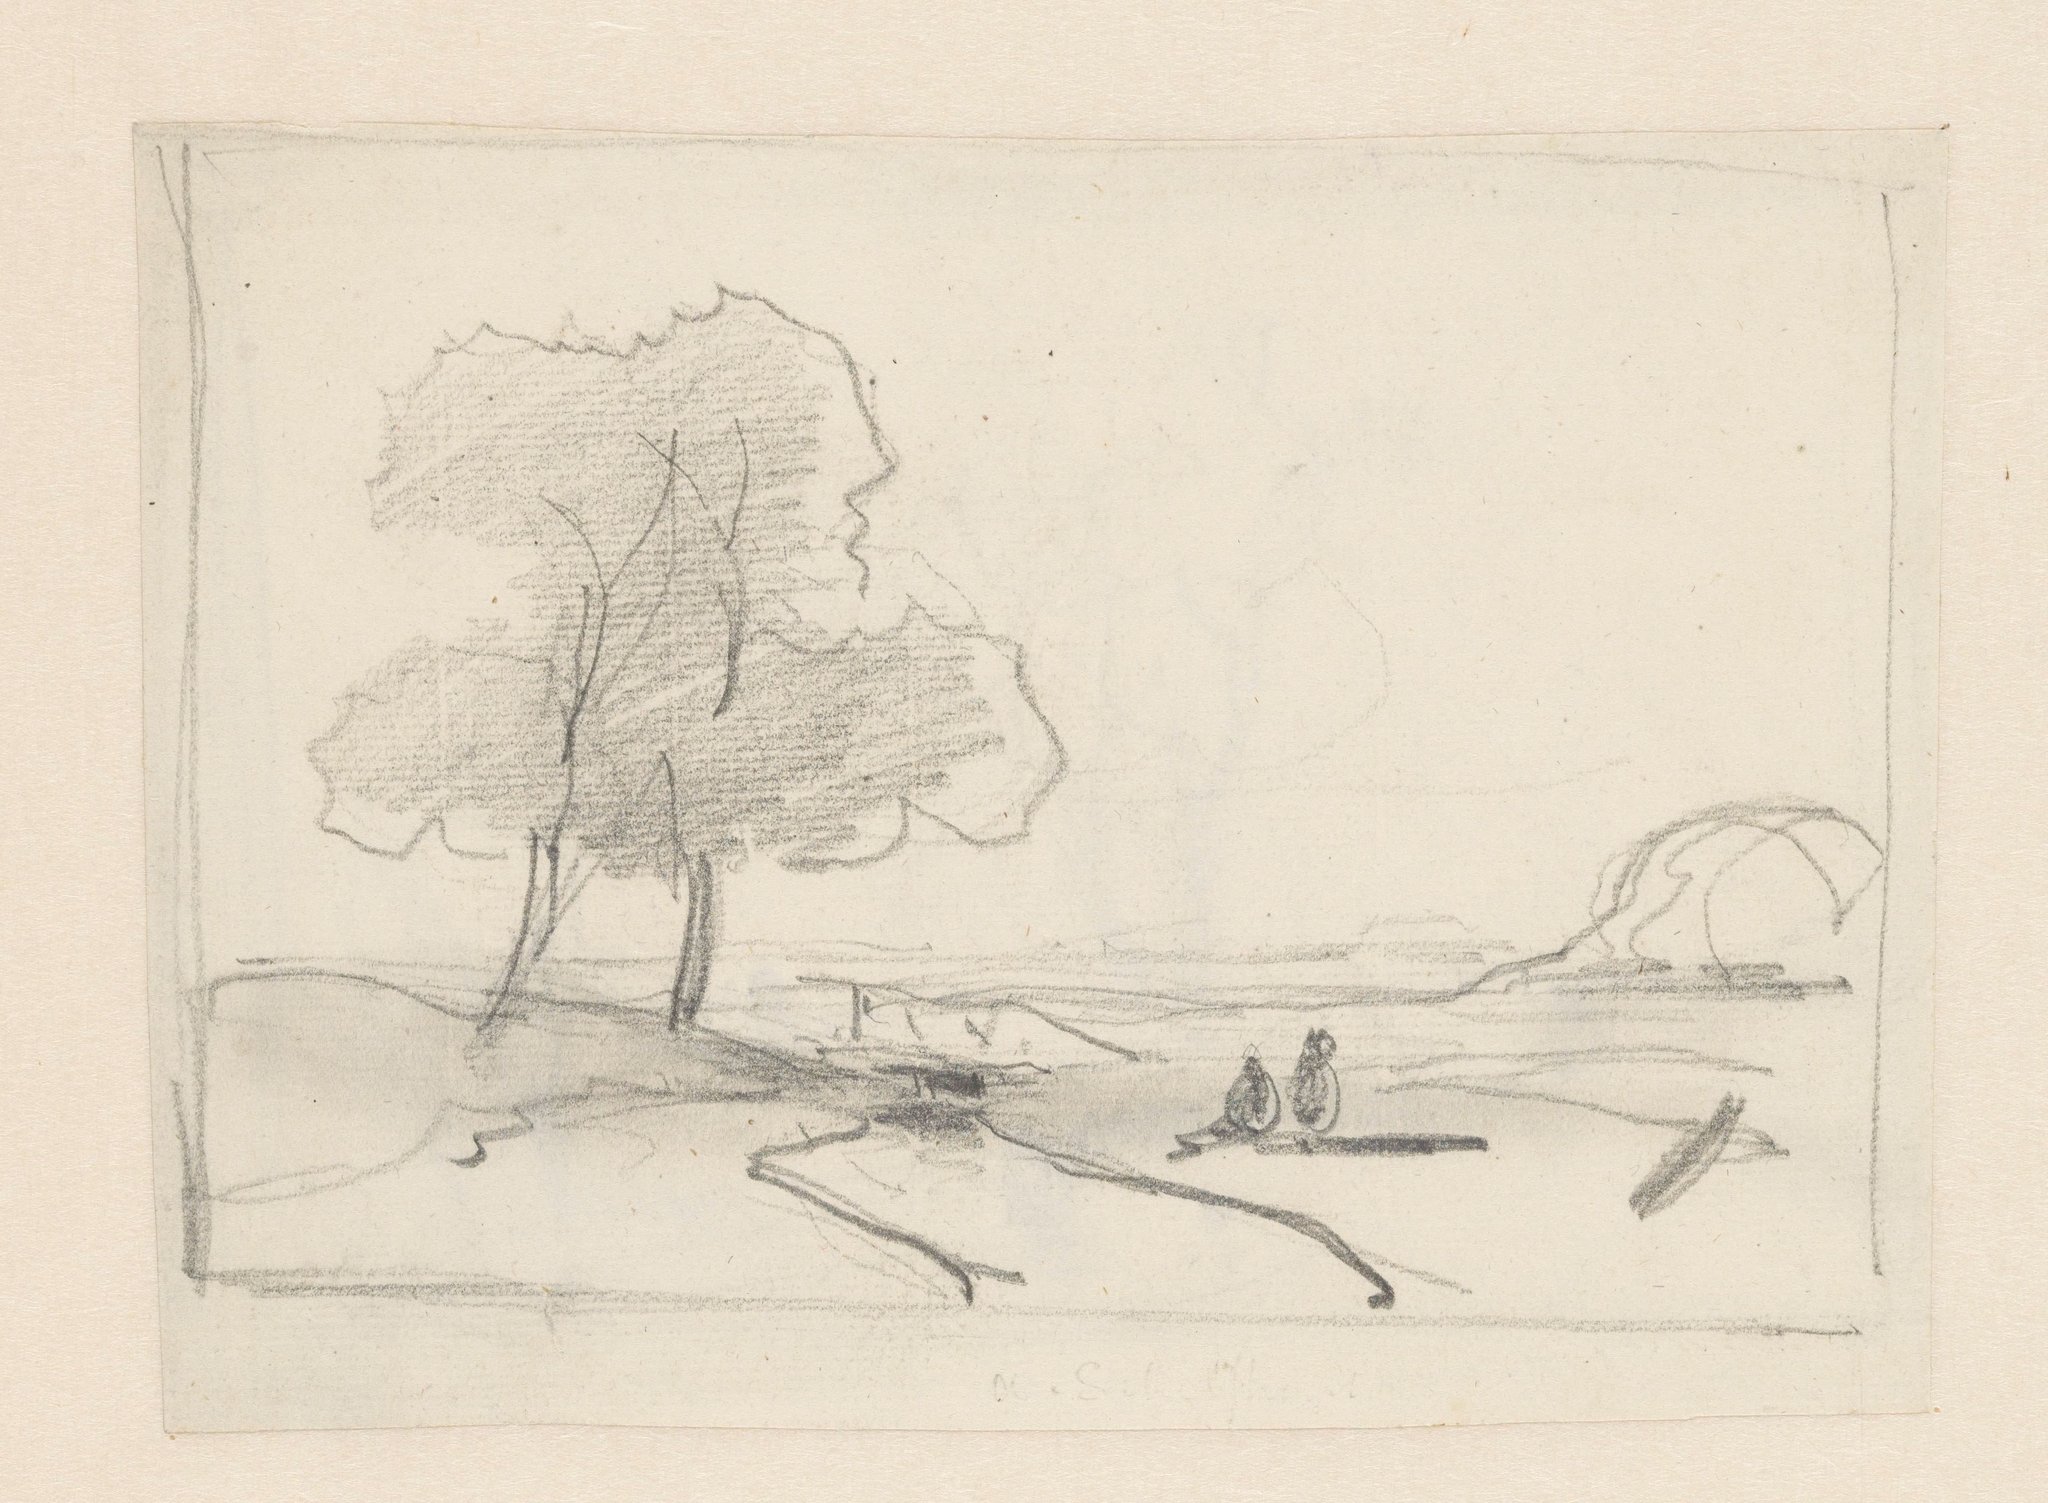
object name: drawing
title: Schets van een landschap met twee zittende figuren en een bomenpartij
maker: andreas schelfhout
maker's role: draughtsman, painter, print maker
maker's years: 1787-1870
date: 1797-1870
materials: paper, pencil